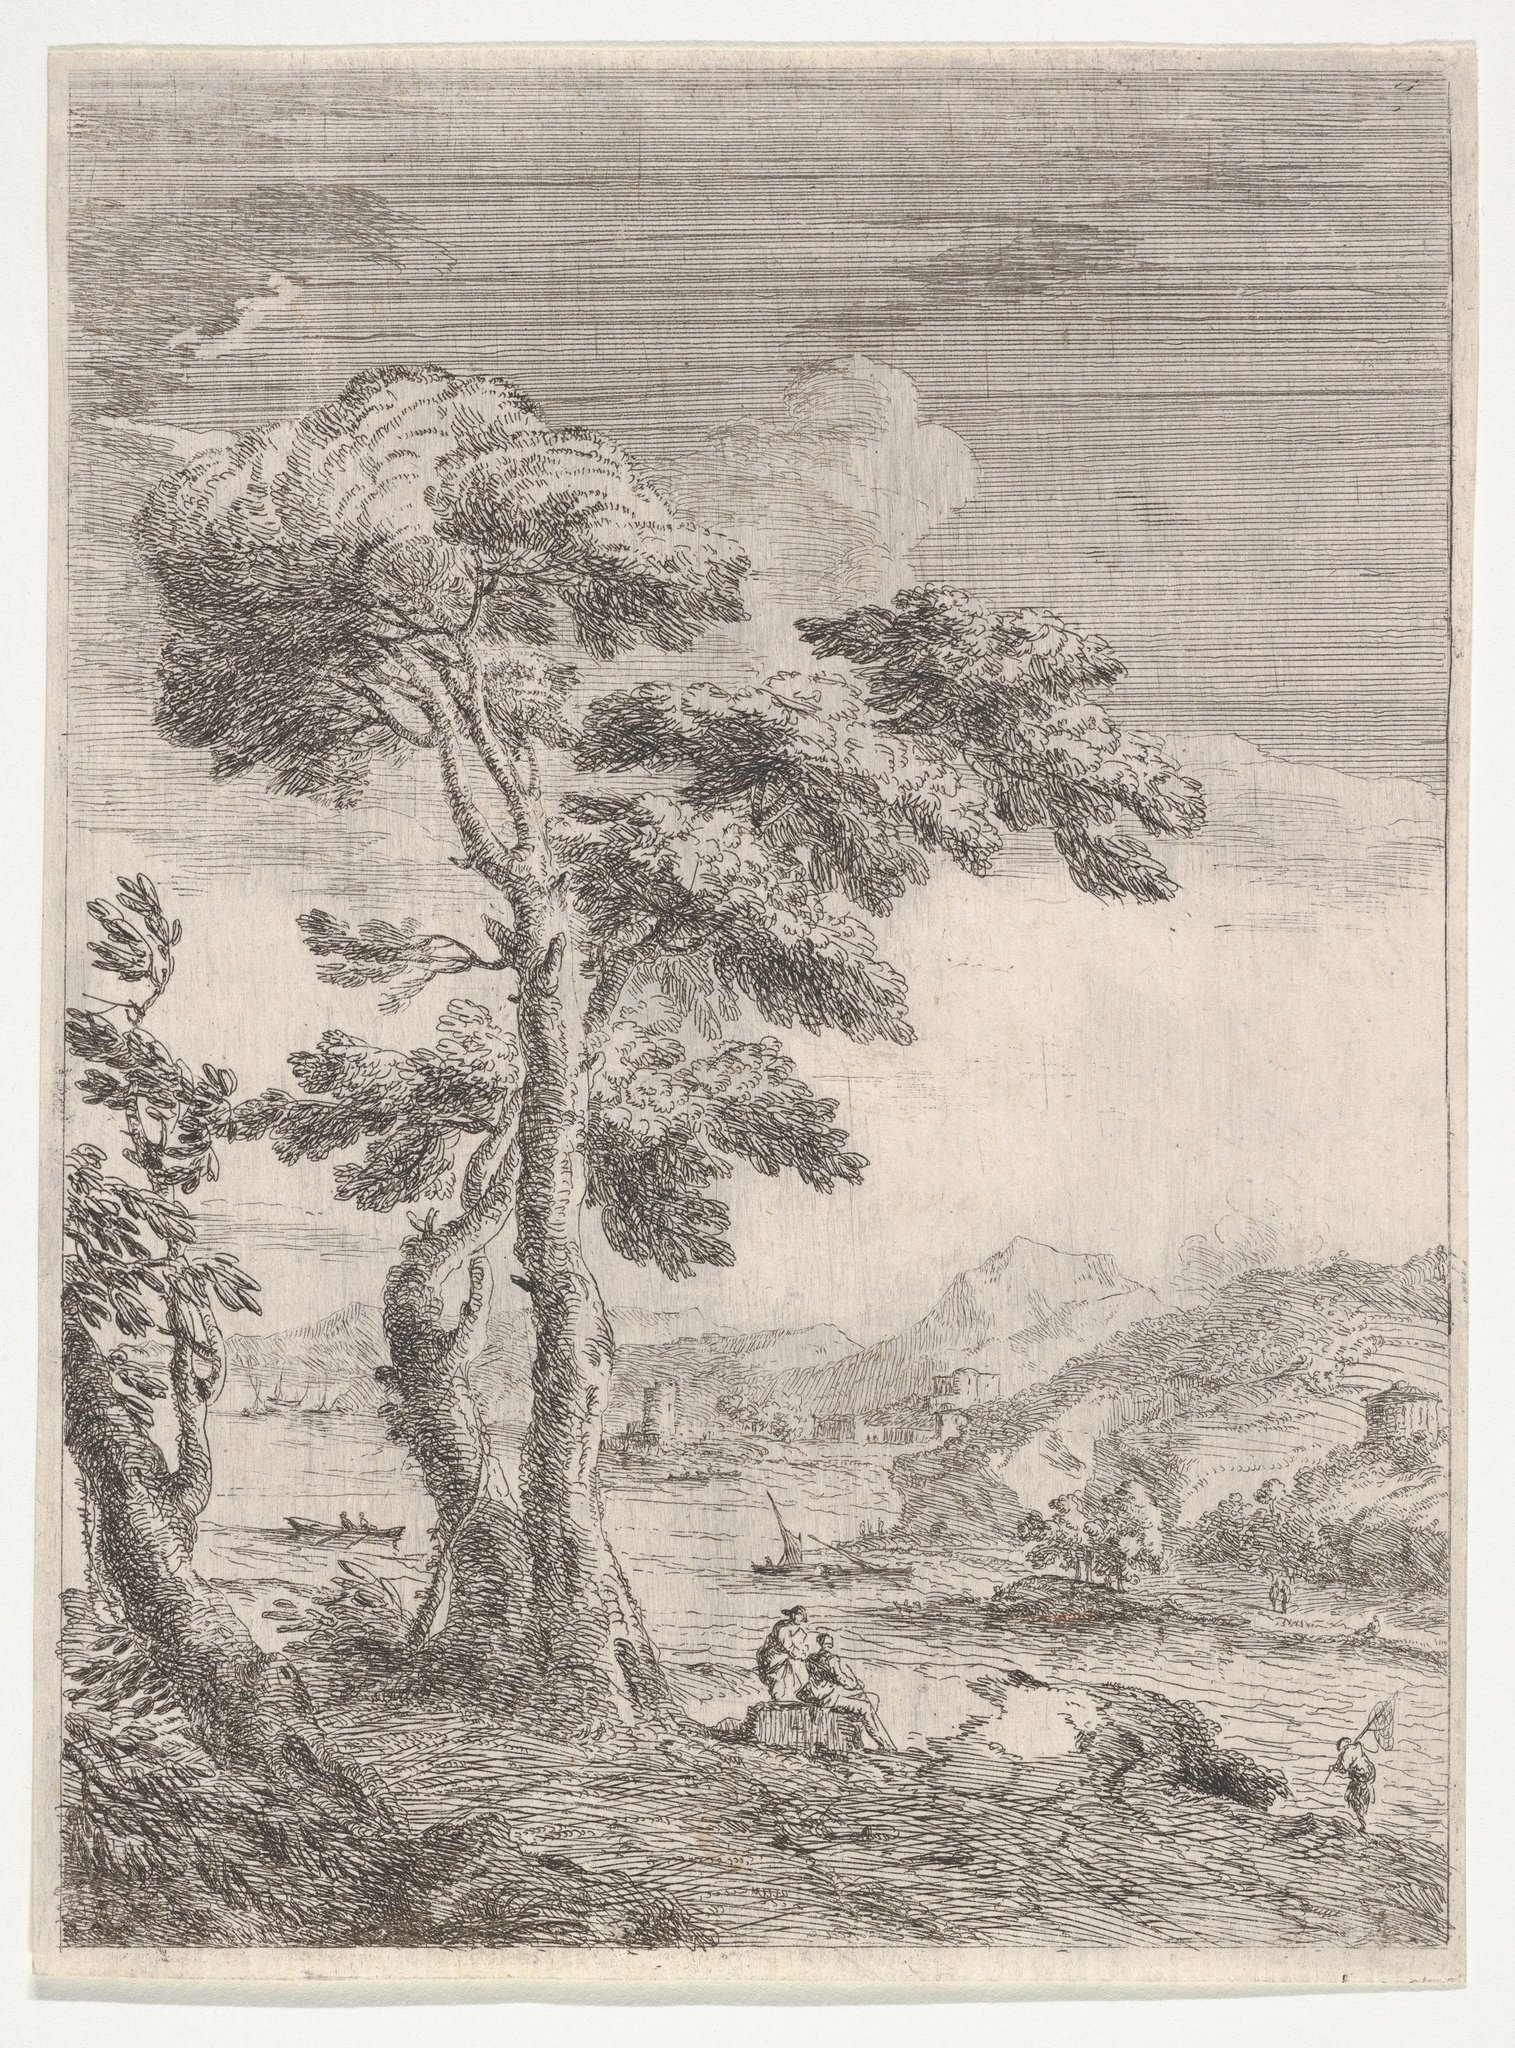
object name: print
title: Pastoral Scene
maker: paolo anesi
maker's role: print maker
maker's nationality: italian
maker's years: 1700-1761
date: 1710-1774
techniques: etching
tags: human figures,pastoral,trees